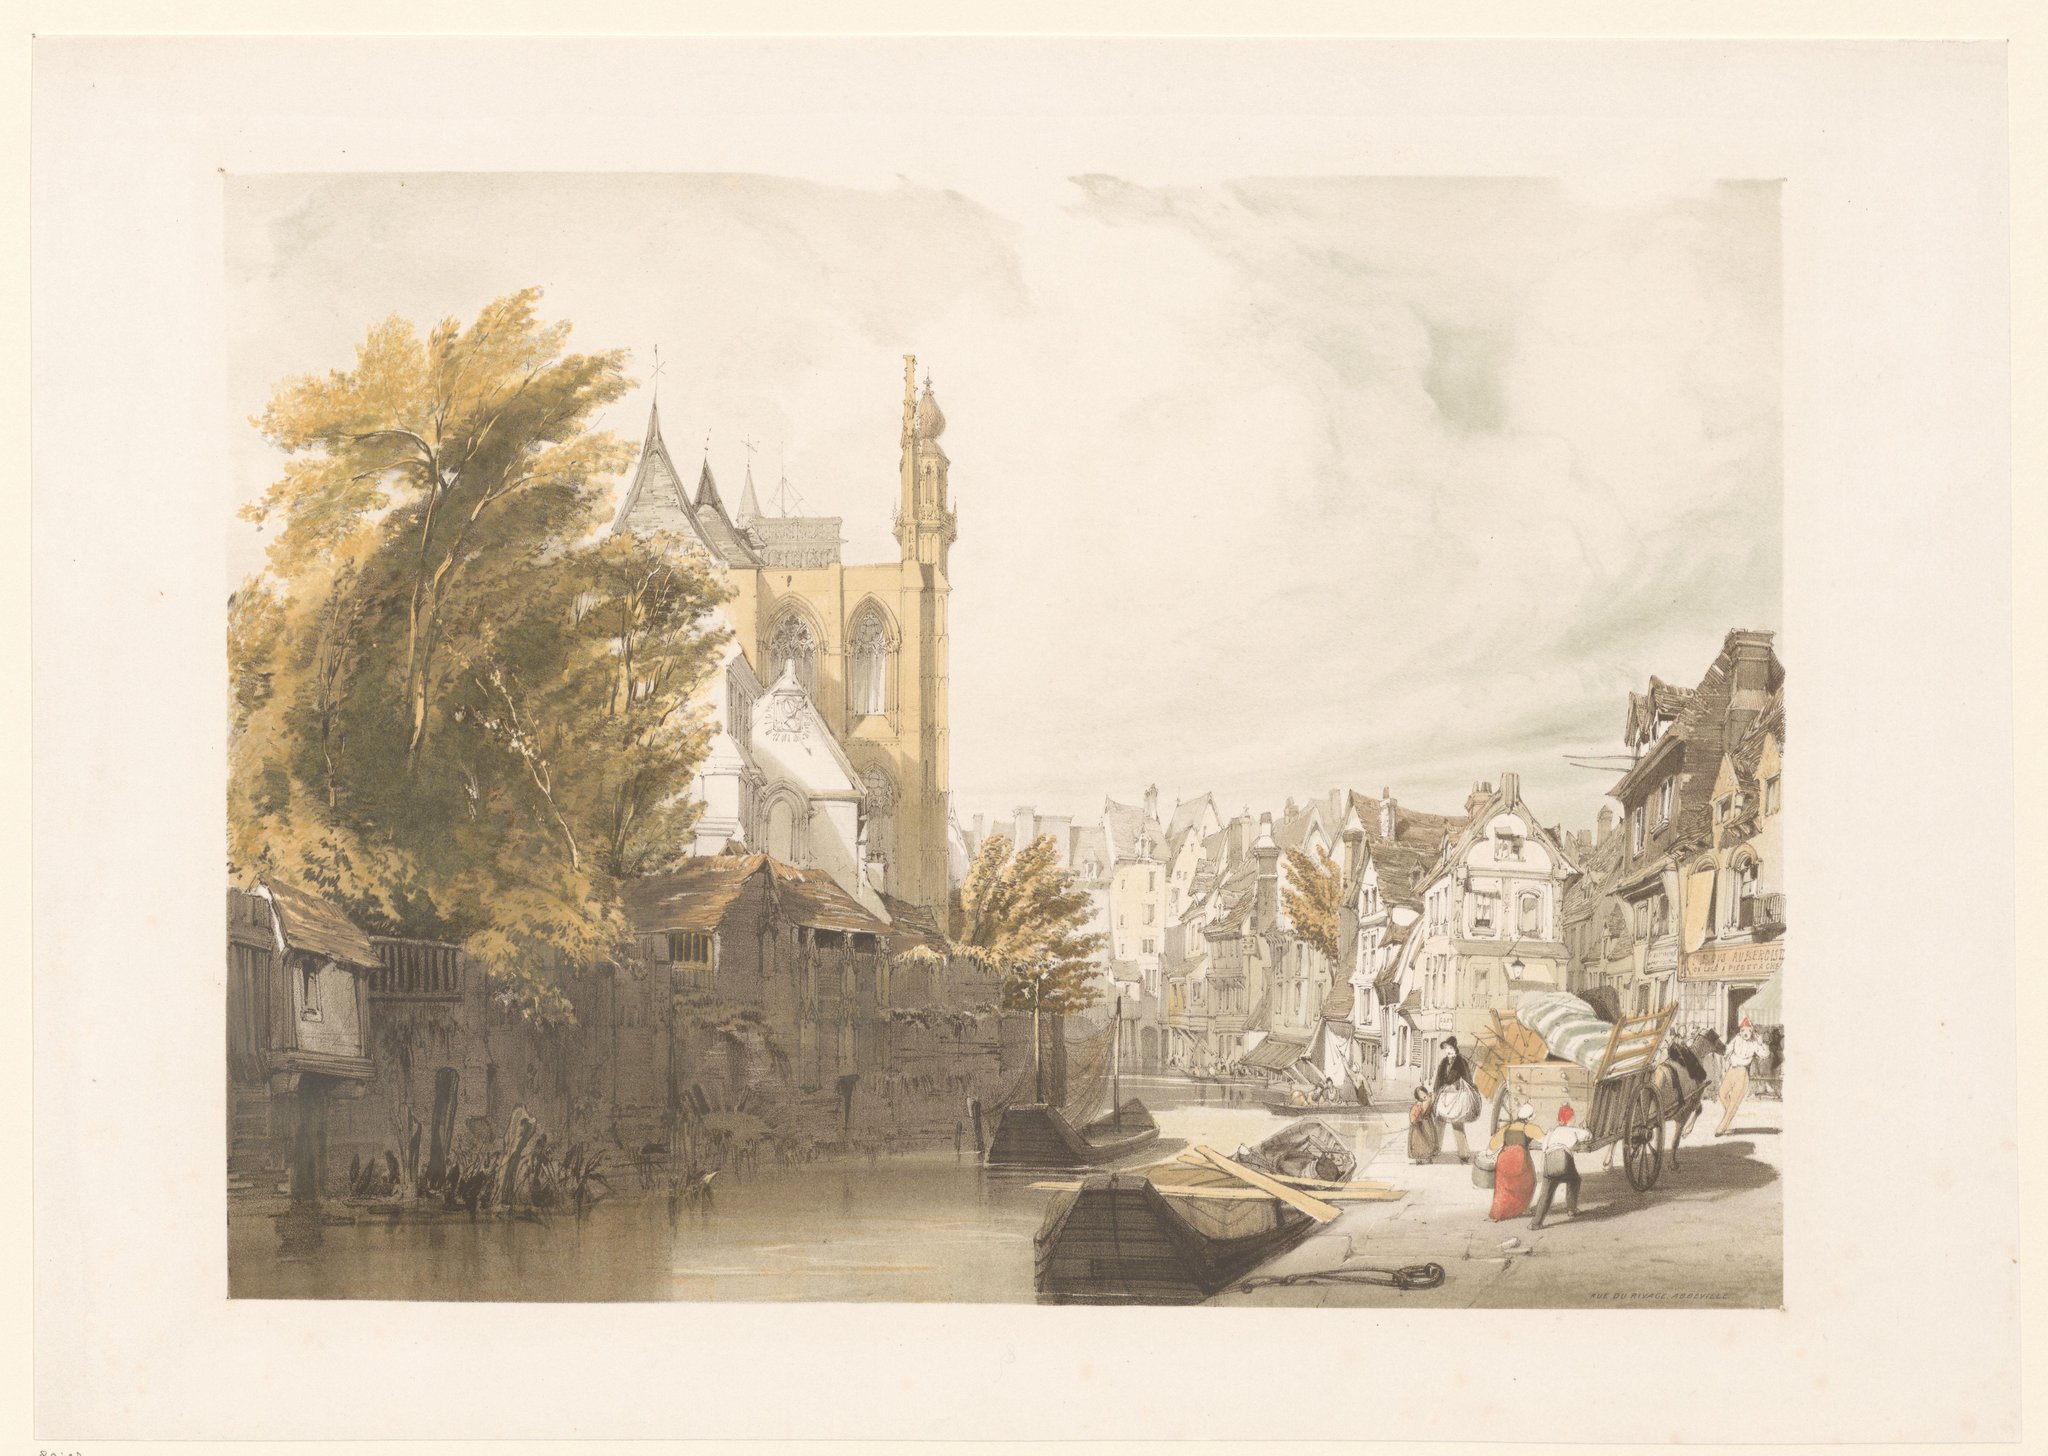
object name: print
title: Rue de Rivage, Abbeville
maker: thomas shotter boys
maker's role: draughtsman, print maker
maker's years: 1803-1874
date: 1839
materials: paper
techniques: lithograph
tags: canals, waters (in city), city-view in general; 'veduta' (+ city(-scape) with figures, staffage)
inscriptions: collector's mark: Lugt 2228, collector's mark: Lugt 2760